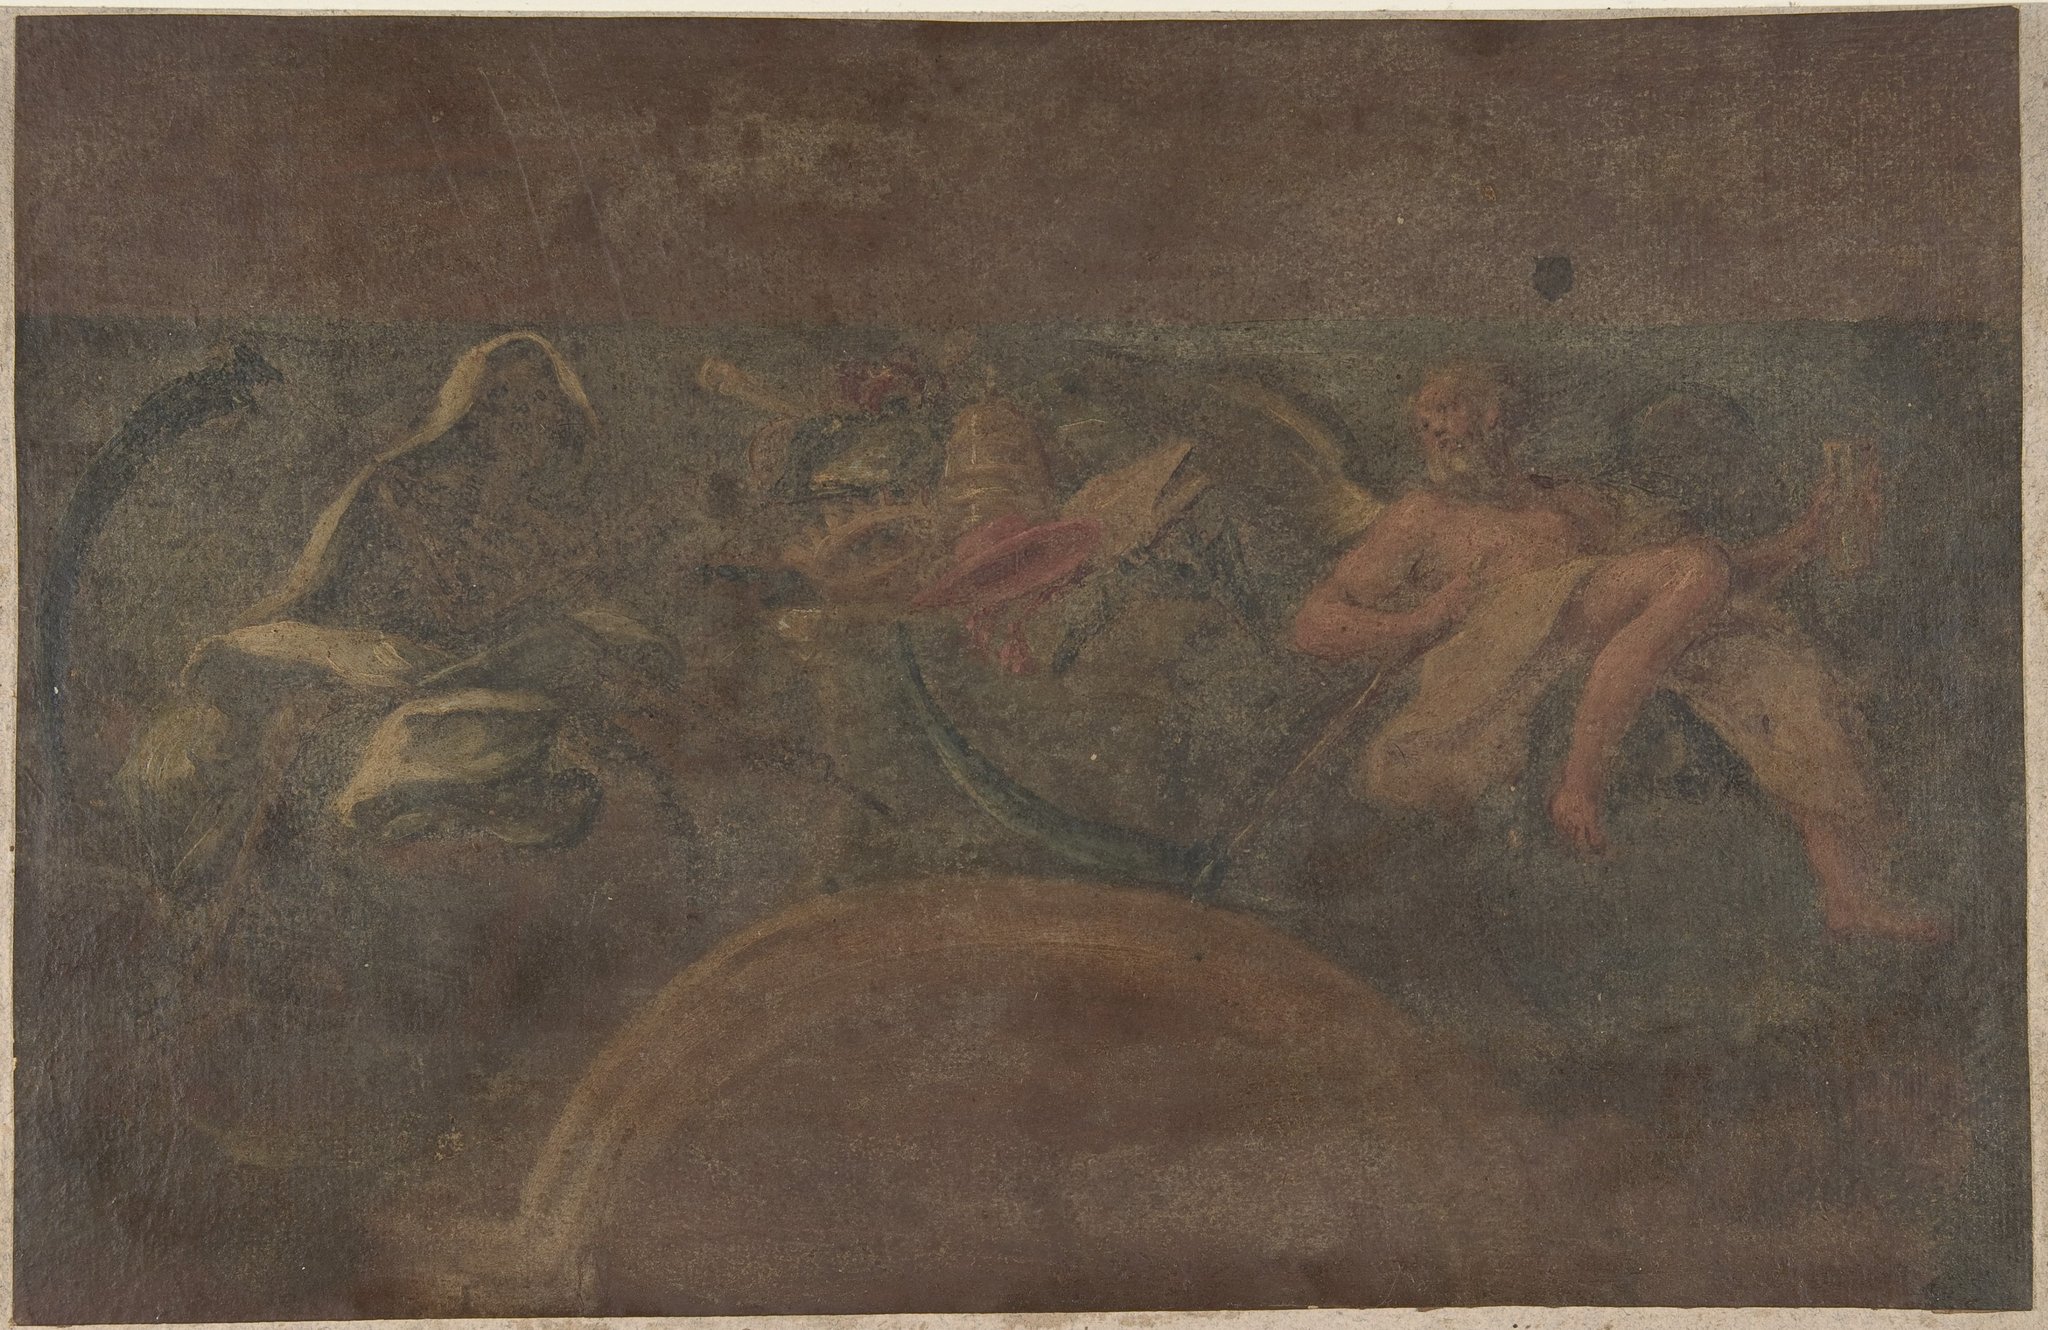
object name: drawing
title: Allegorical Figures of Time and Death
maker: anonymous, italian, 18th century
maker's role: artist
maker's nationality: italian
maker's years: 1700-1800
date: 1701-1800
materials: oil, paper